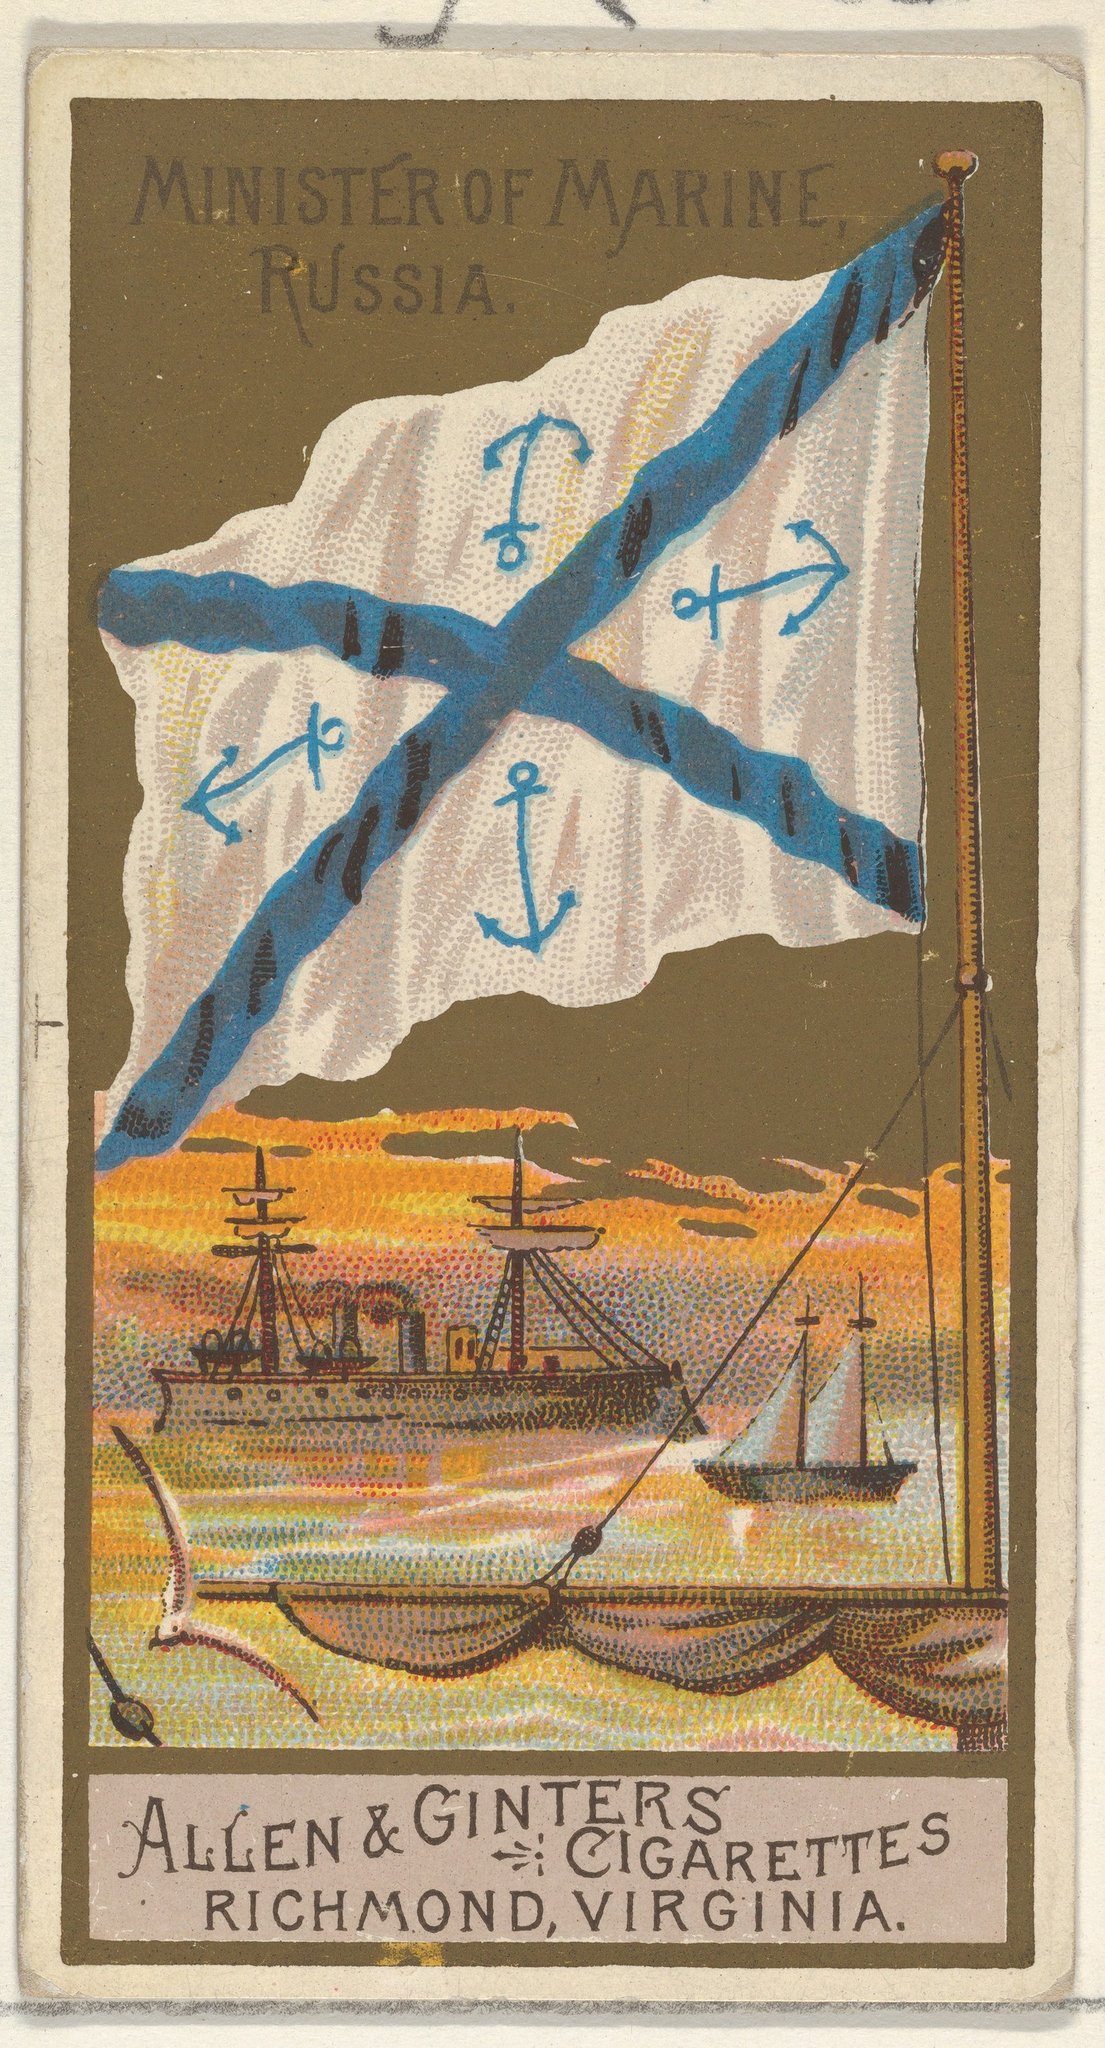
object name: print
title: Minister of Marine, Russia, from the Naval Flags series (N17) for Allen & Ginter Cigarettes Brands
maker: allen & ginter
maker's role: publisher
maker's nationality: american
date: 1888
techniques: color lithograph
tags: flags